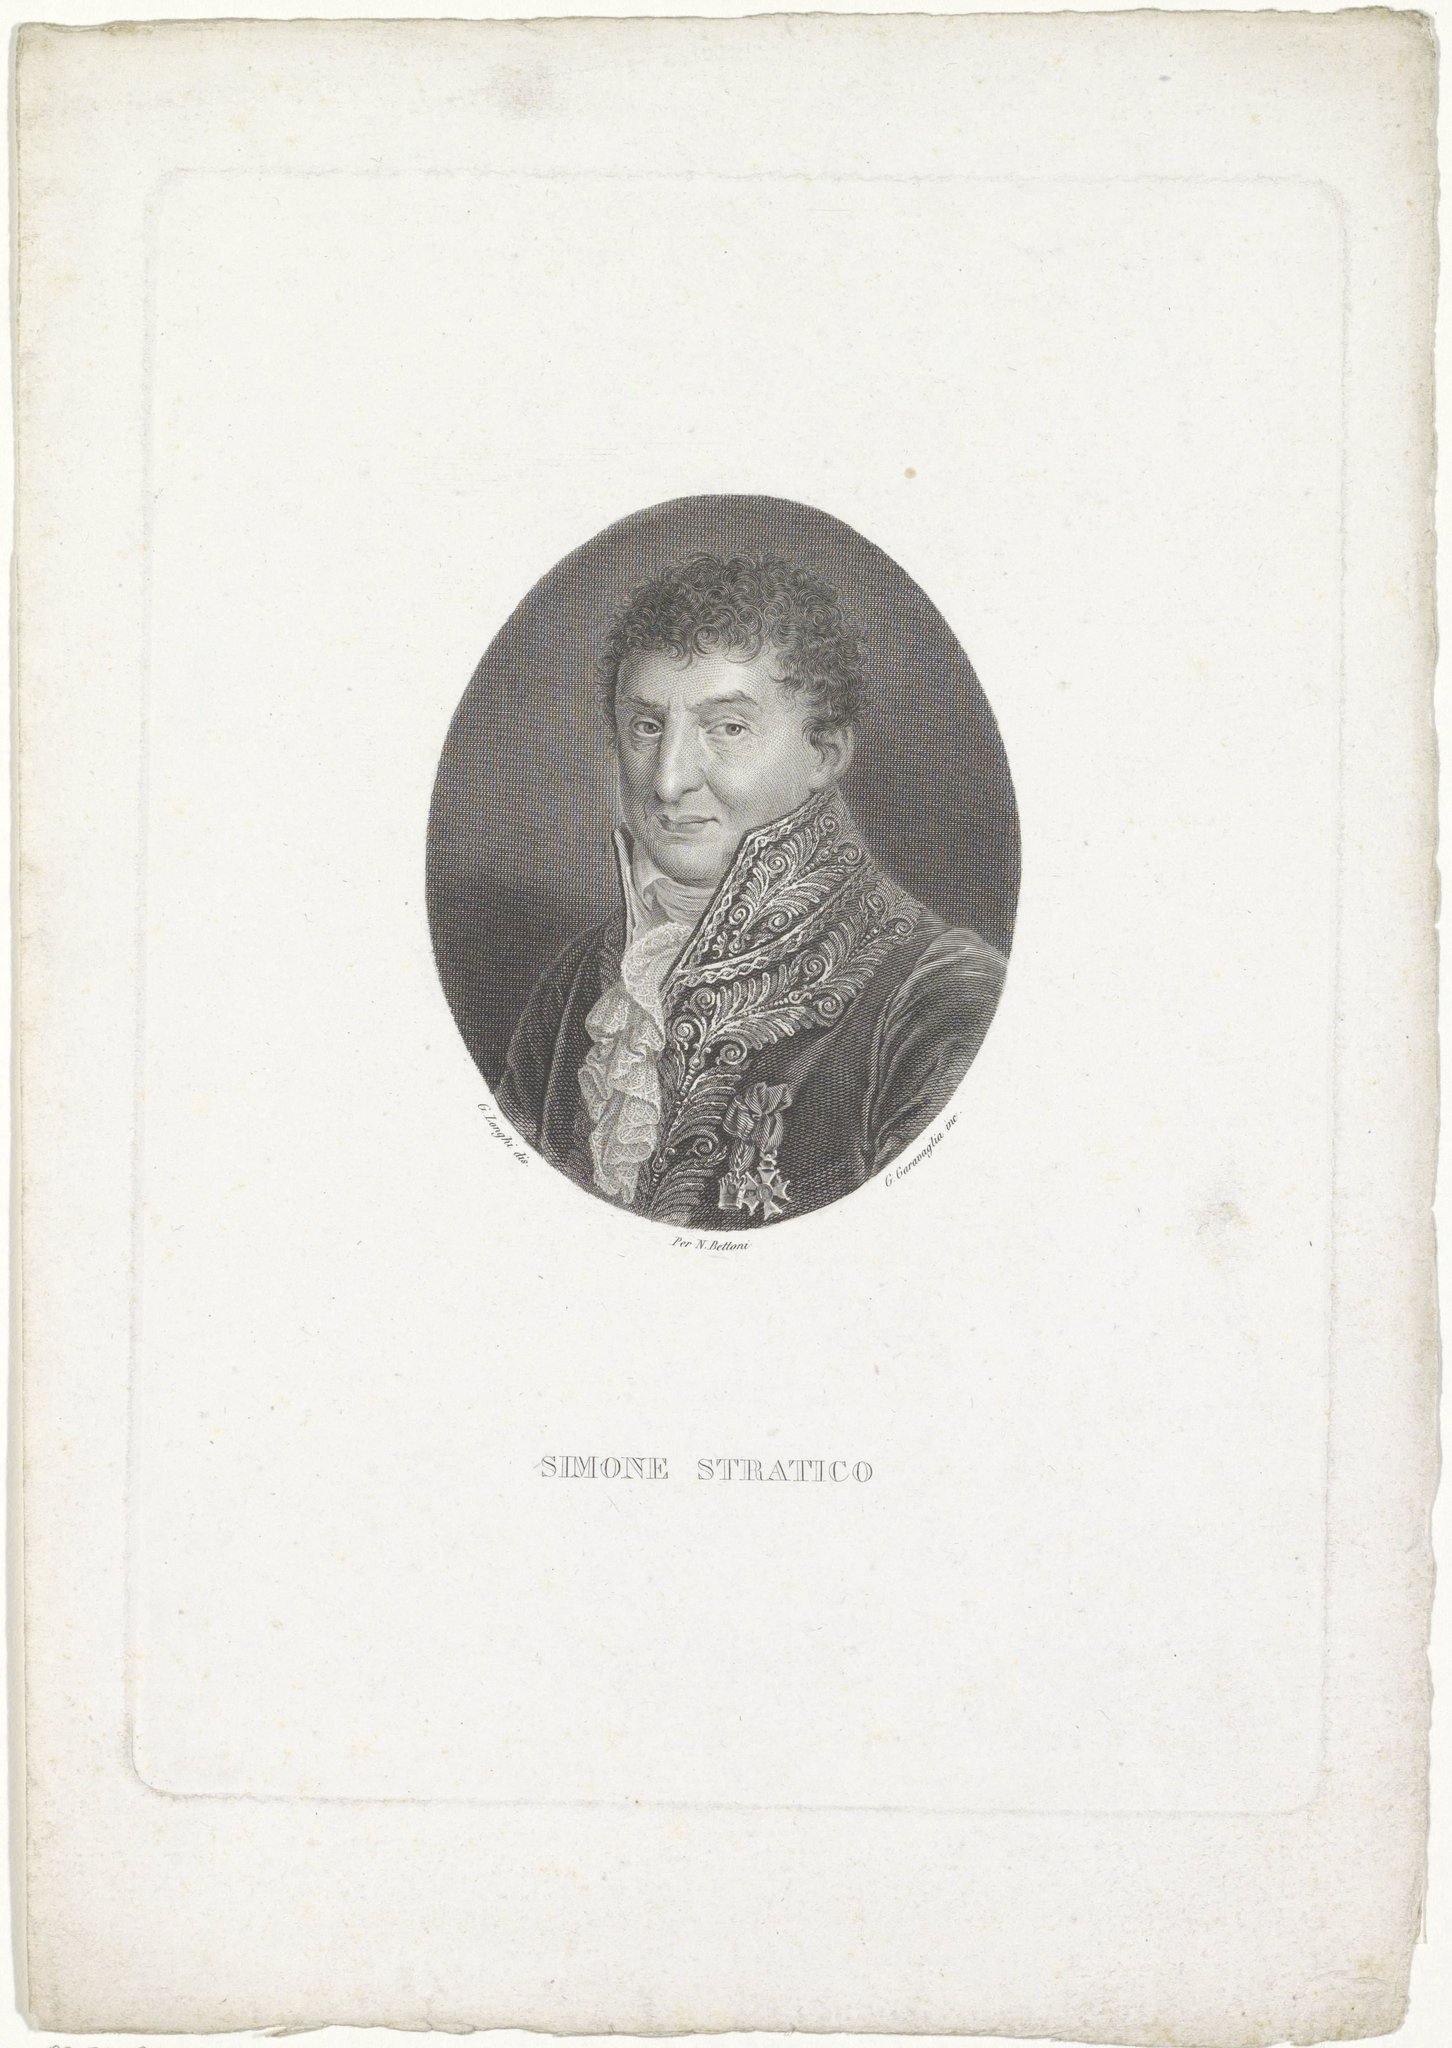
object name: print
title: Portret van wetenschapper Simone Stratico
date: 1800-1835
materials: paper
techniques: engraving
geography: italy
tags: physicist, historical persons, science and technology (+ portrait of scholar, scientist)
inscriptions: collector's mark: Lugt 2228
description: Deze prent maakt deel uit van een reeks portretprenten van onbekende omvang. De reeks is in meerdere staten uitgegeven. De eerste staat met enkel het portret in ovaal. Een tweede staat met naam van de geportretteerde in holle letters onder de voorstelling. Een derde staat met de naam van de geportretteerde in gevulde letters onder de voorstelling. En een vierde staat met een rechthoekig kader rondom het ovale portret.